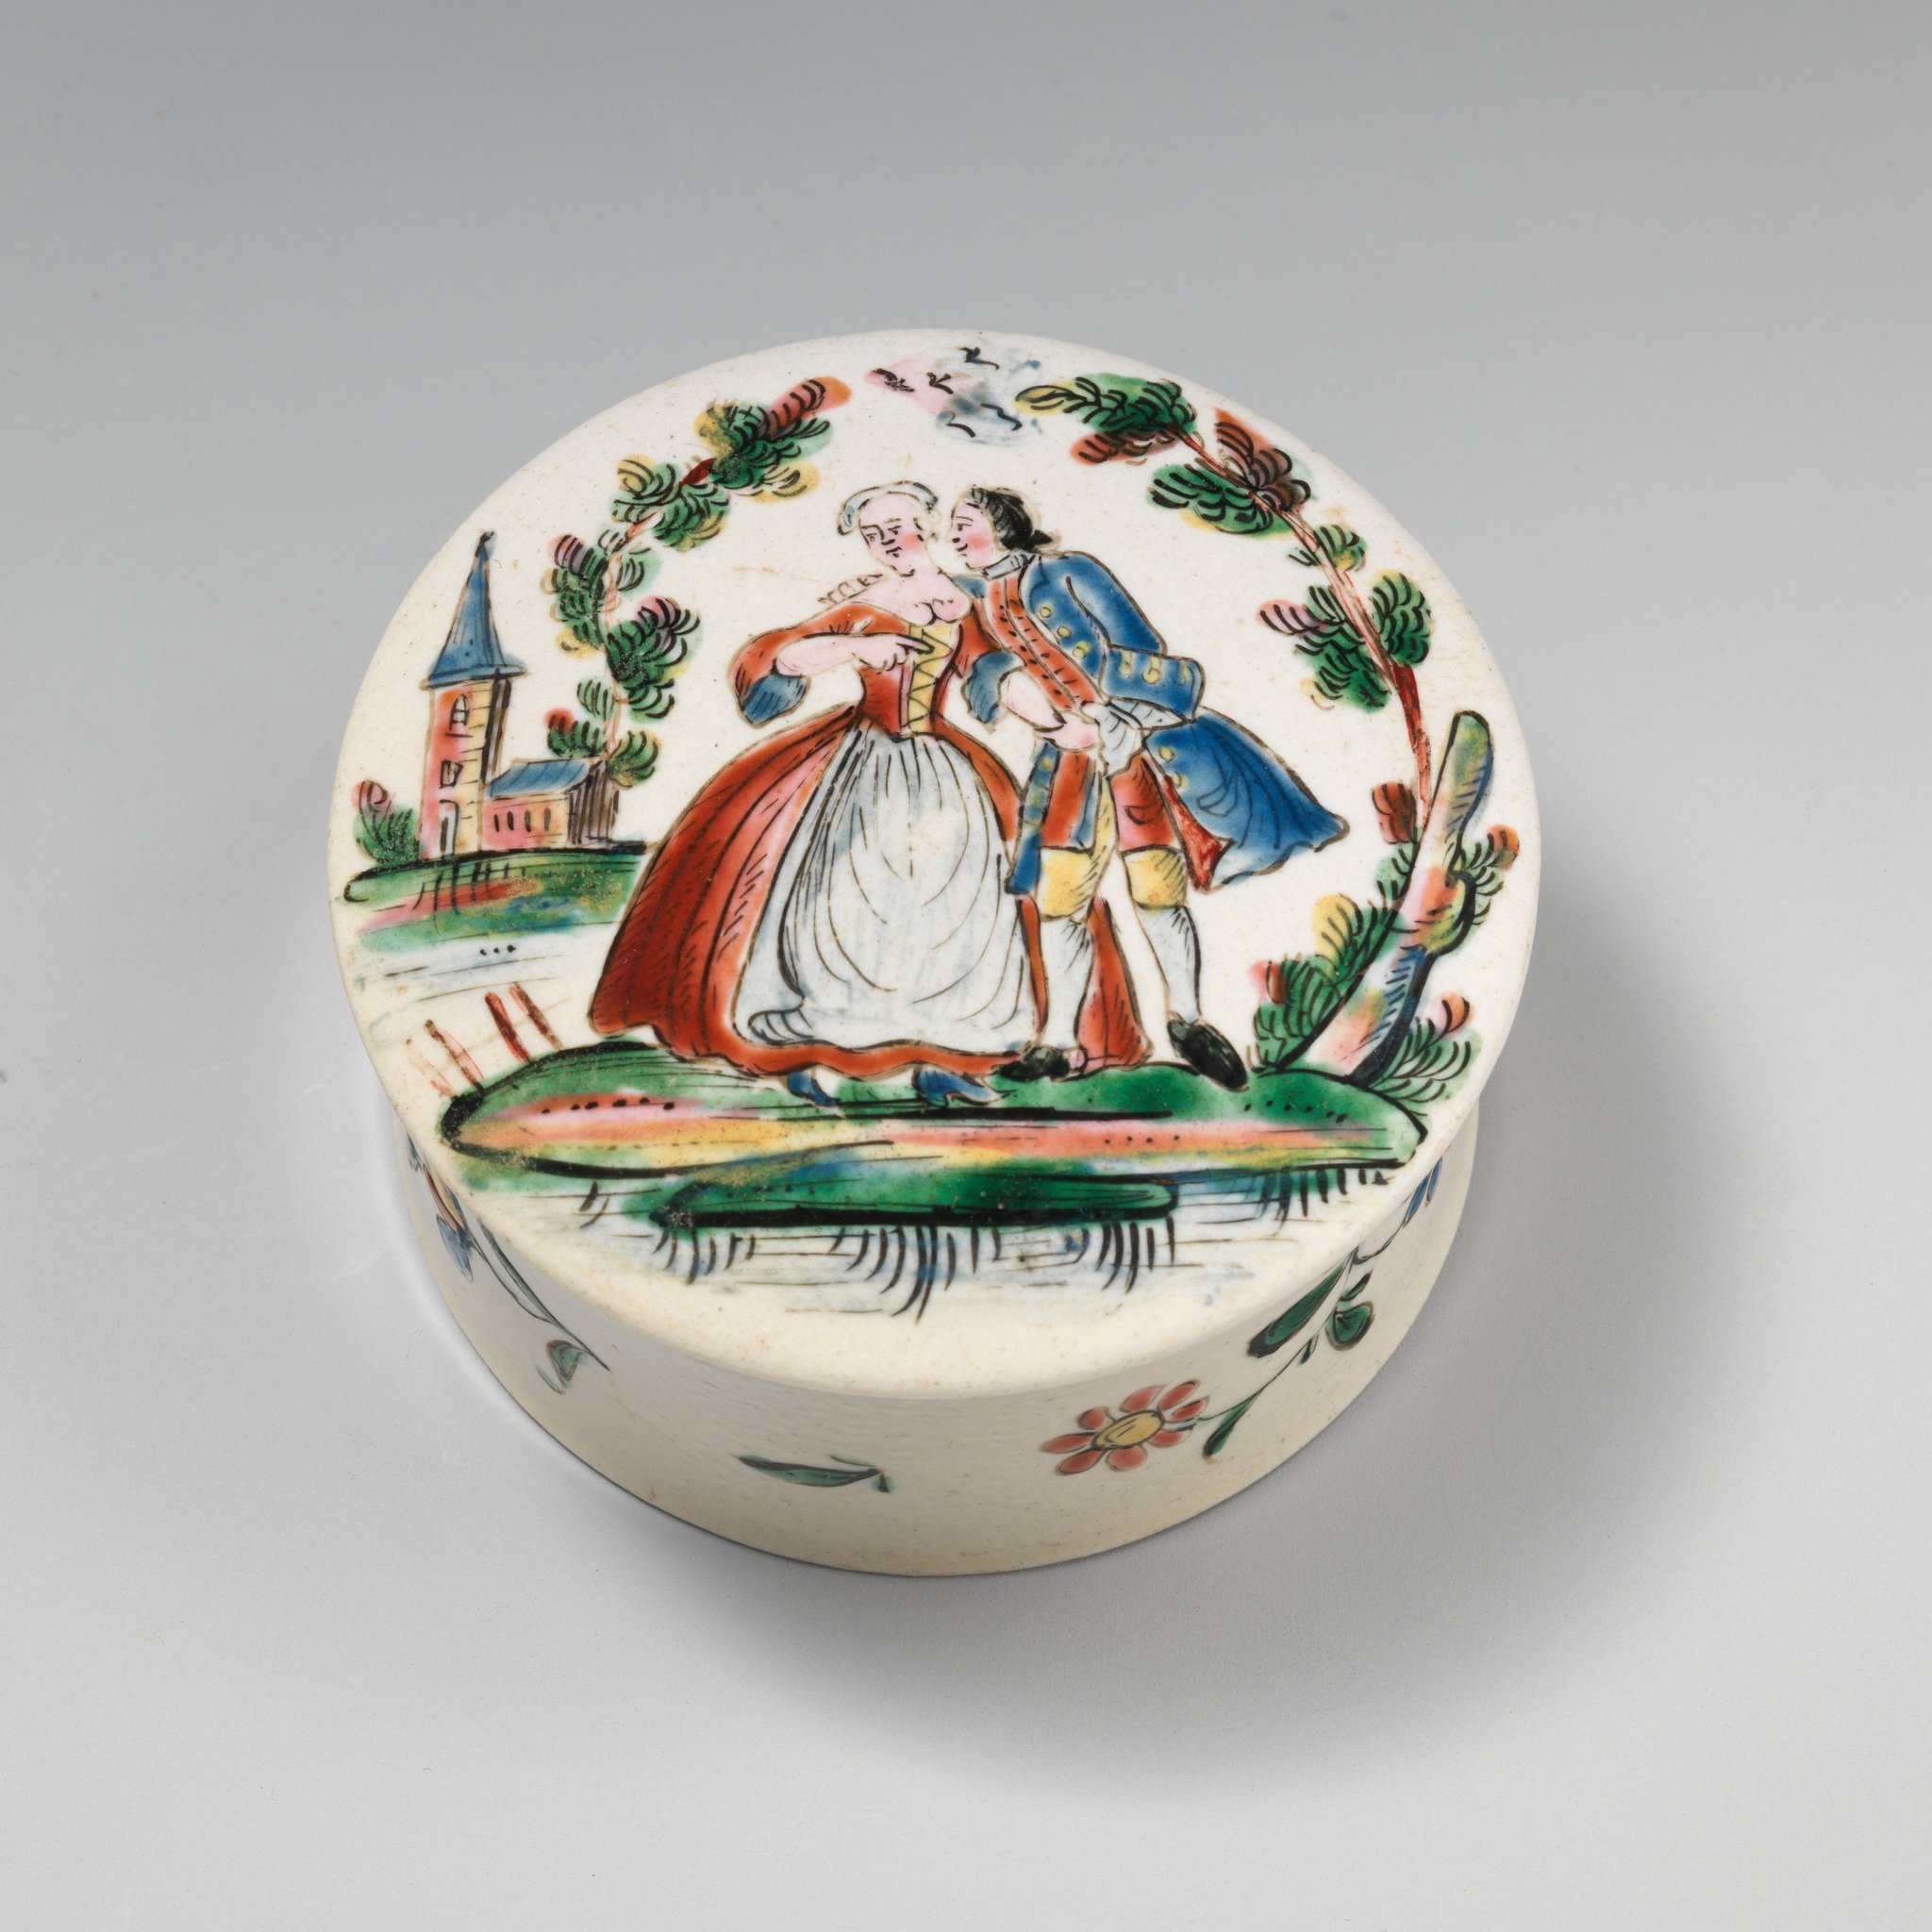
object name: pomade box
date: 1765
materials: stoneware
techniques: salt glaze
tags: couples,men,women